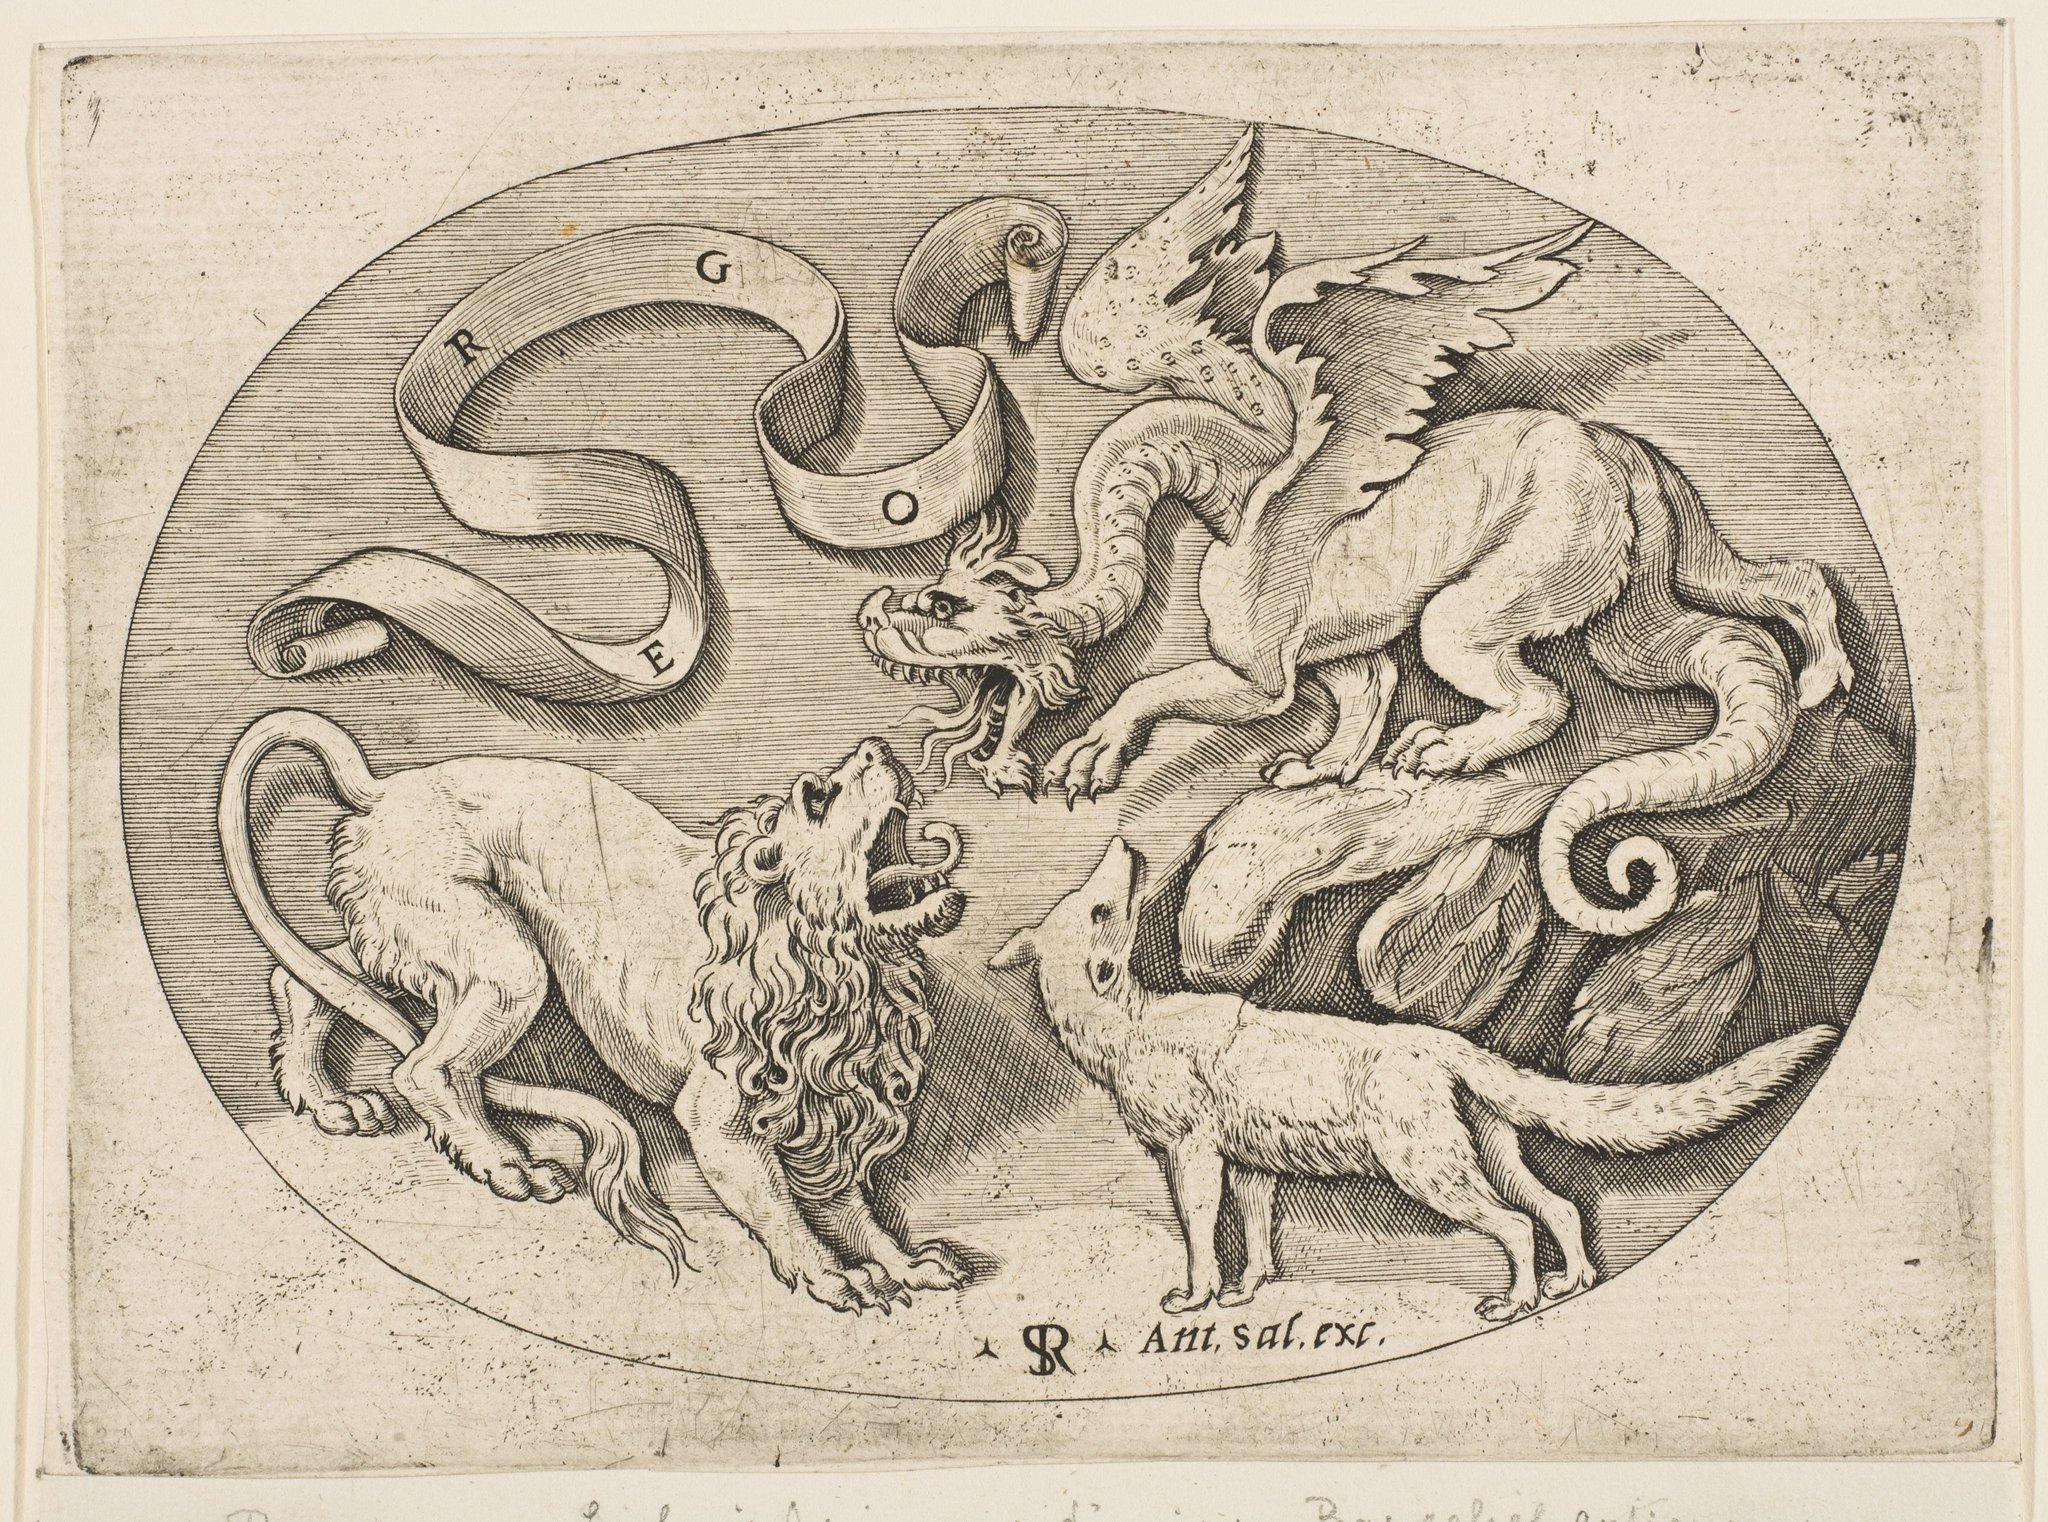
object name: print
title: A lion, dragon and fox fighting each other, an inscribed banderole above, an oval composition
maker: marco dente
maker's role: artist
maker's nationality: italian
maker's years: 1515-1527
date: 1515-1527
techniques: engraving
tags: dragons,foxes,lions